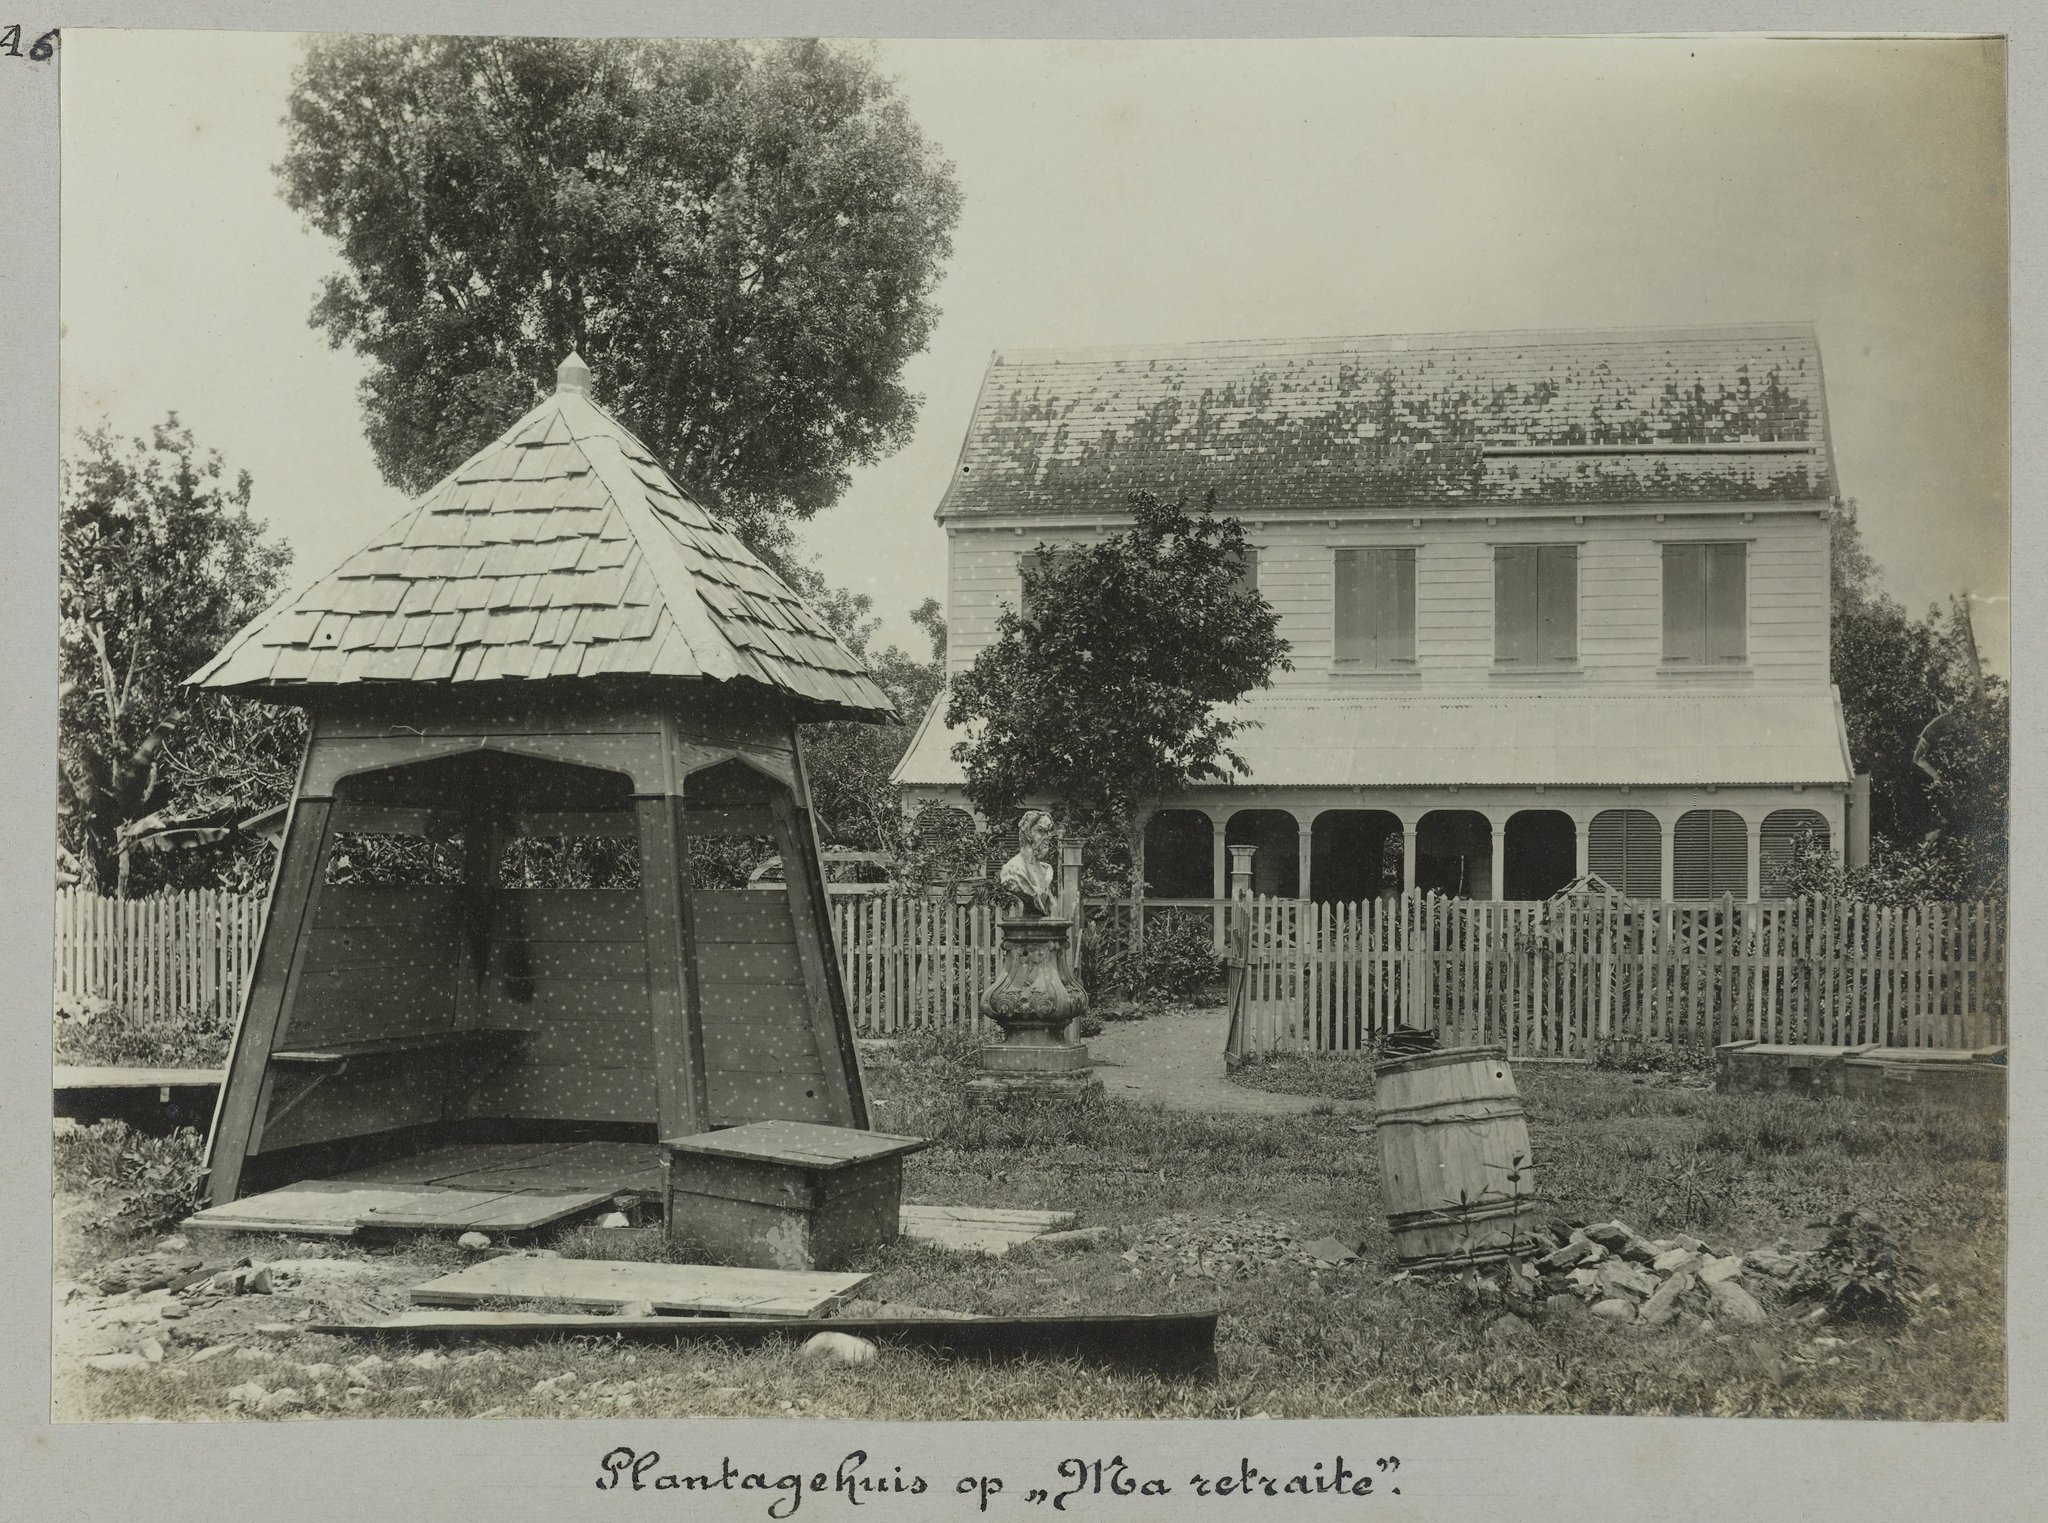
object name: photograph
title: Plantagehuis op "Ma retraite"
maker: hendrik doijer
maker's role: engineer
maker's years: 1863-1925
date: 1903-1910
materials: photographic support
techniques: gelatin silver print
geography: suriname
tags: suriname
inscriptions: inscription: ‘A6 / Plantagehuis op "Ma retraite".’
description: Het plantagehuis op de plantage Ma Retraite. Buiten het hek in de tuin een soort theehuisje, een borstbeeld op een voetstuk en rondslingerende rommel. Onderdeel van het fotoalbum Souvenir de Voyage (deel 1), over het leven van de familie Doijer in en rond de plantage Ma Retraite in Suriname in de jaren 1903-1910.